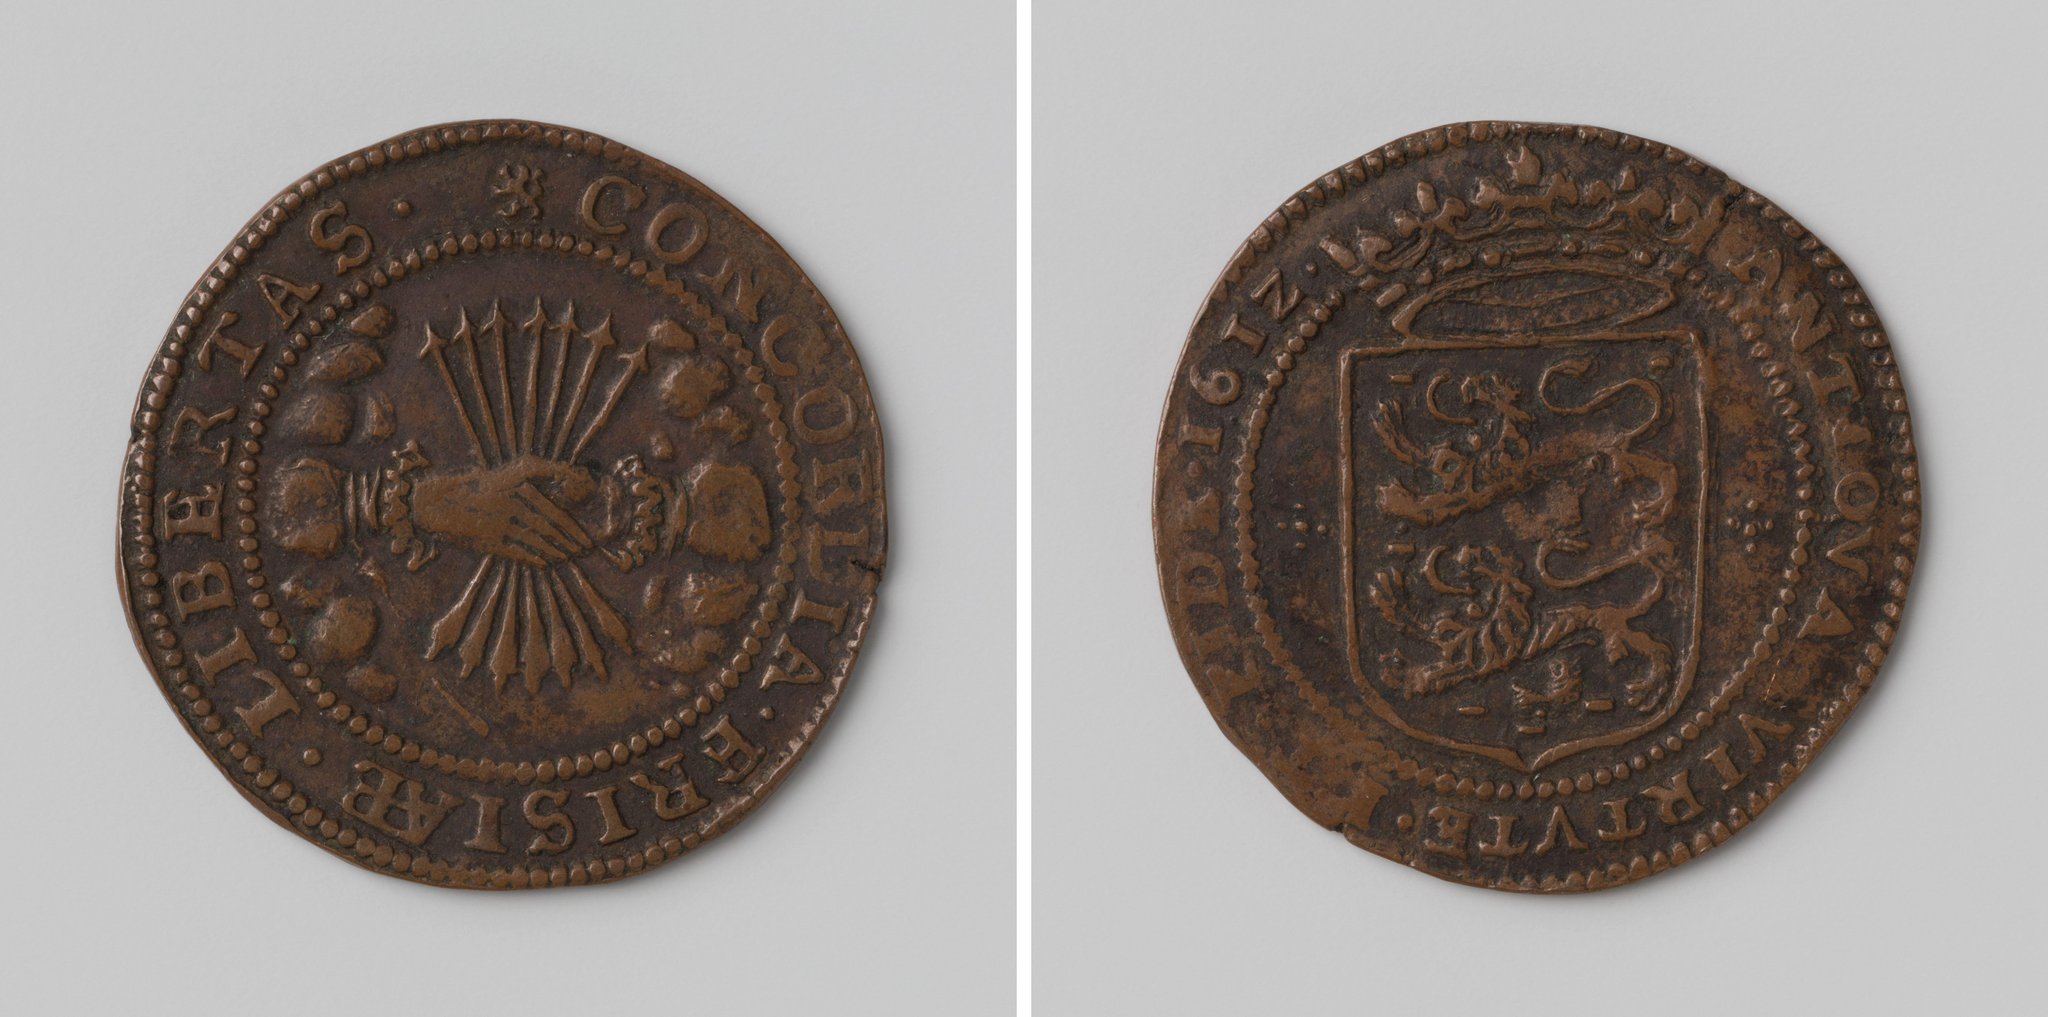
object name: jeton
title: Aansporing tot eensgezindheid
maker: Anonymous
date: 1612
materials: copper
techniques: striking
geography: hoorn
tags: staten van west-friesland, west-friesland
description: Koperen penning. Voorzijde: twee ineen geslagen handen houden samen bundel van zeven pijlen vast binnen omschrift. Keerzijde: gekroond wapenschild binnen omschrift